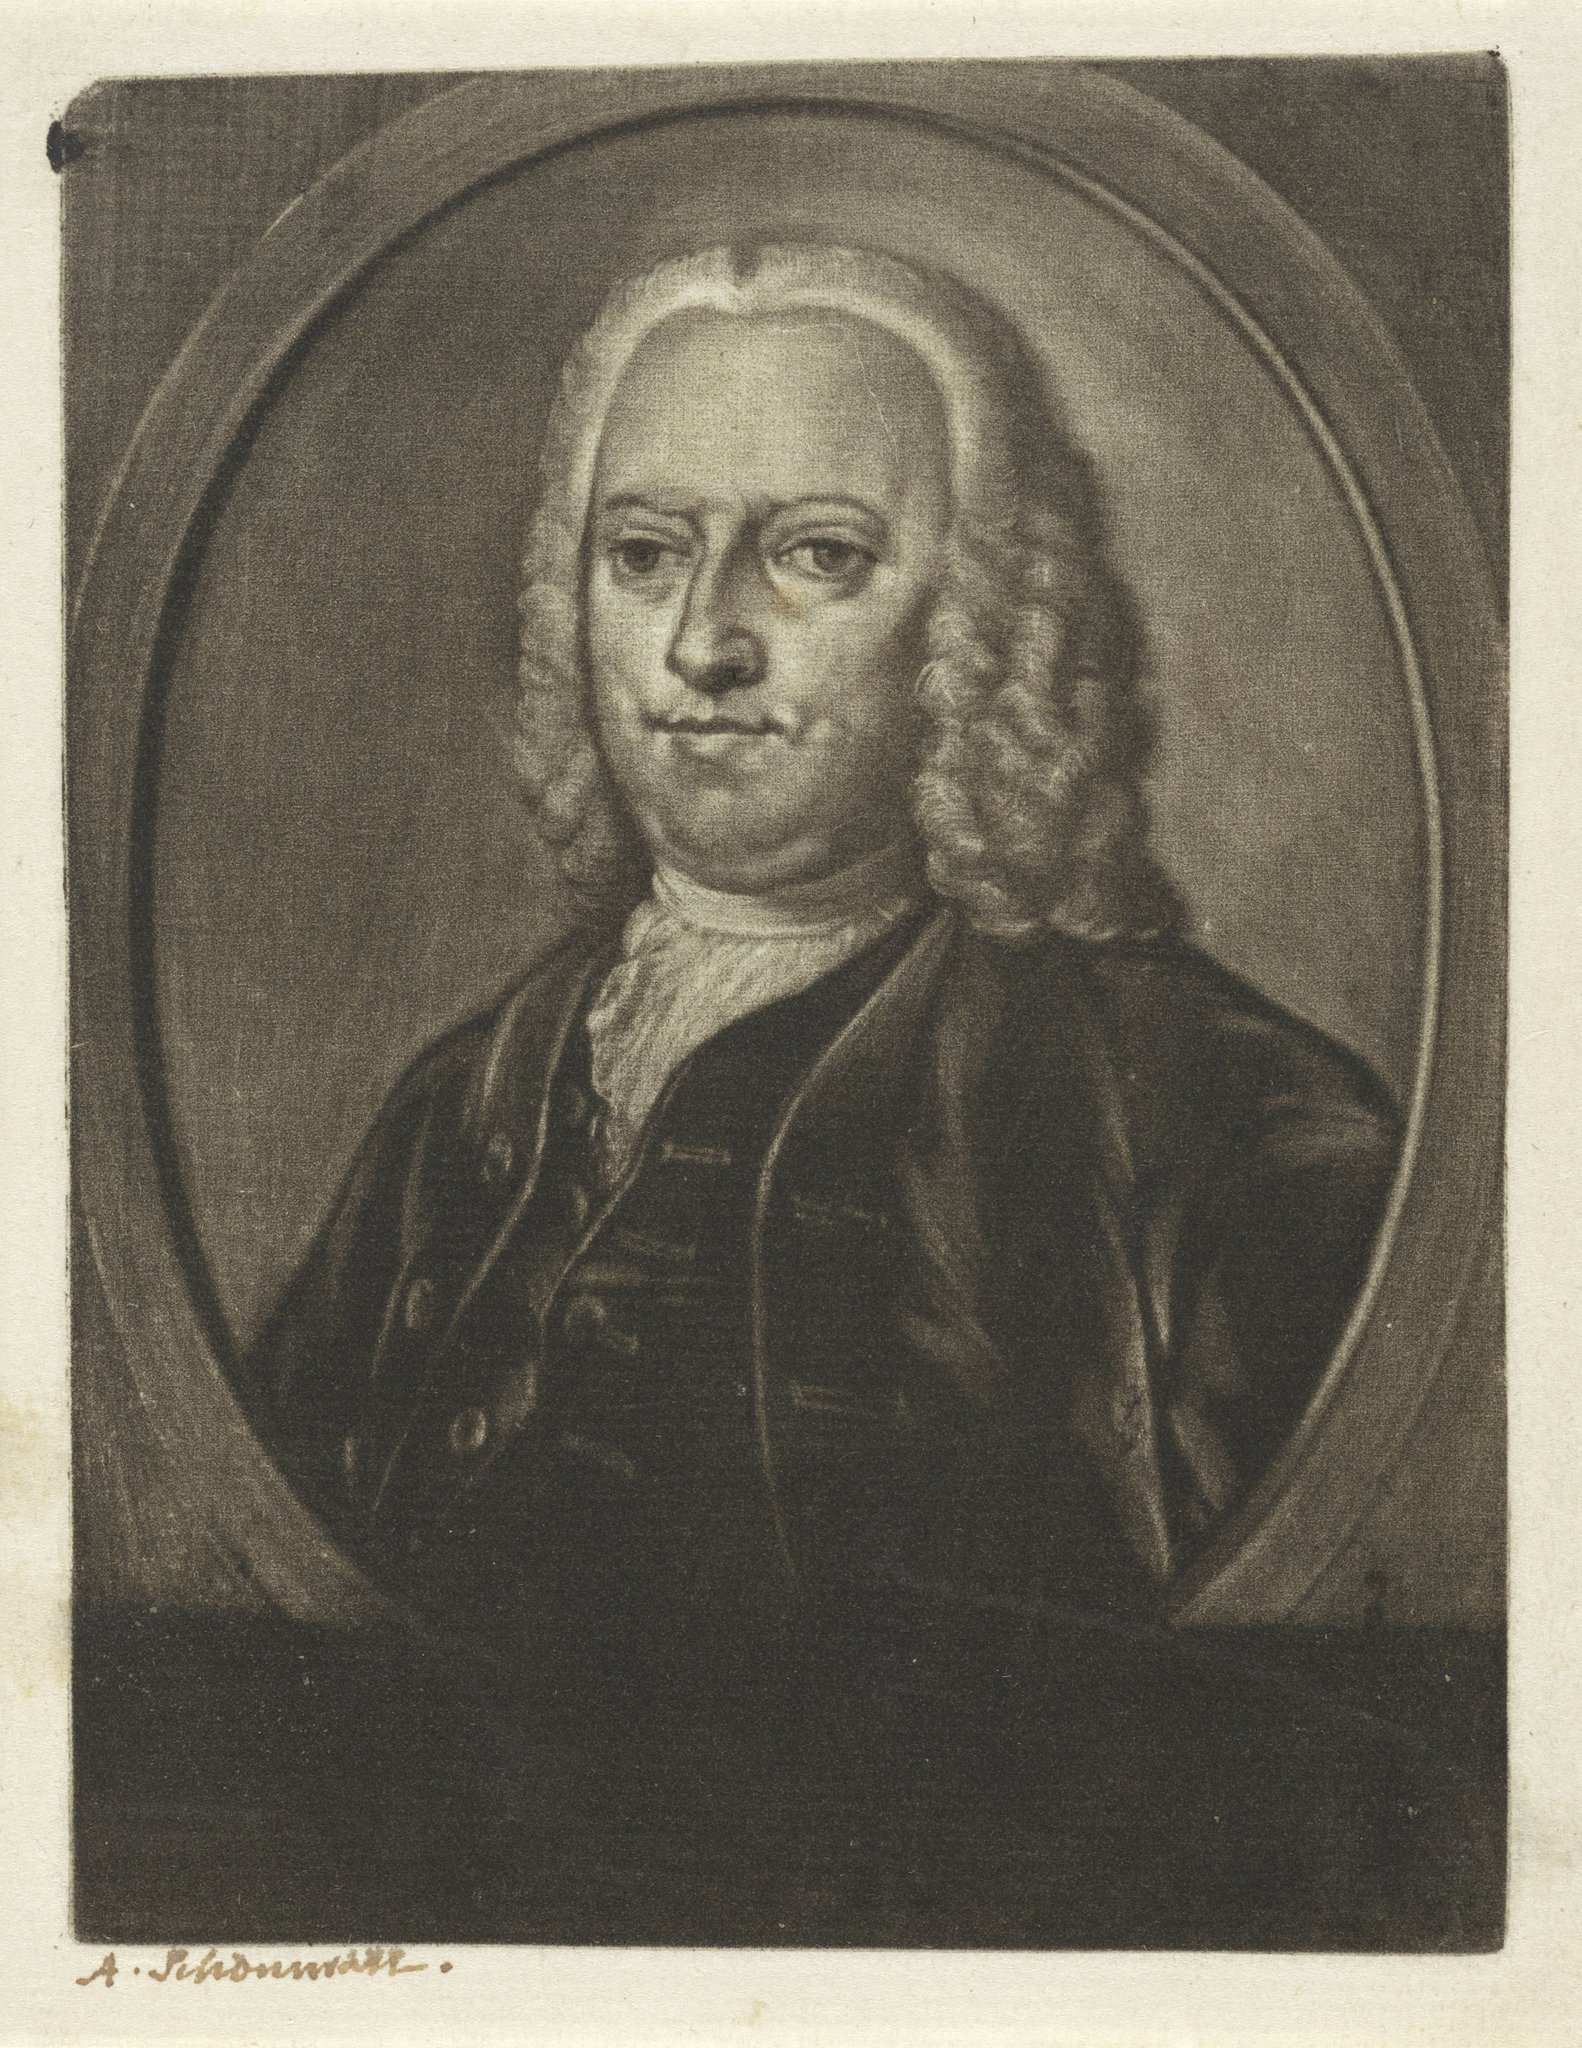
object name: print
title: Portret van een man, mogelijk Johan van der Linden van Slingeland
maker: aert schouman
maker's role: draughtsman, painter, print maker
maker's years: 1710-1792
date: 1720-1792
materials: paper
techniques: mezzotint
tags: johan van der linden van slingelandt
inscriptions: collector's mark: Lugt 2228